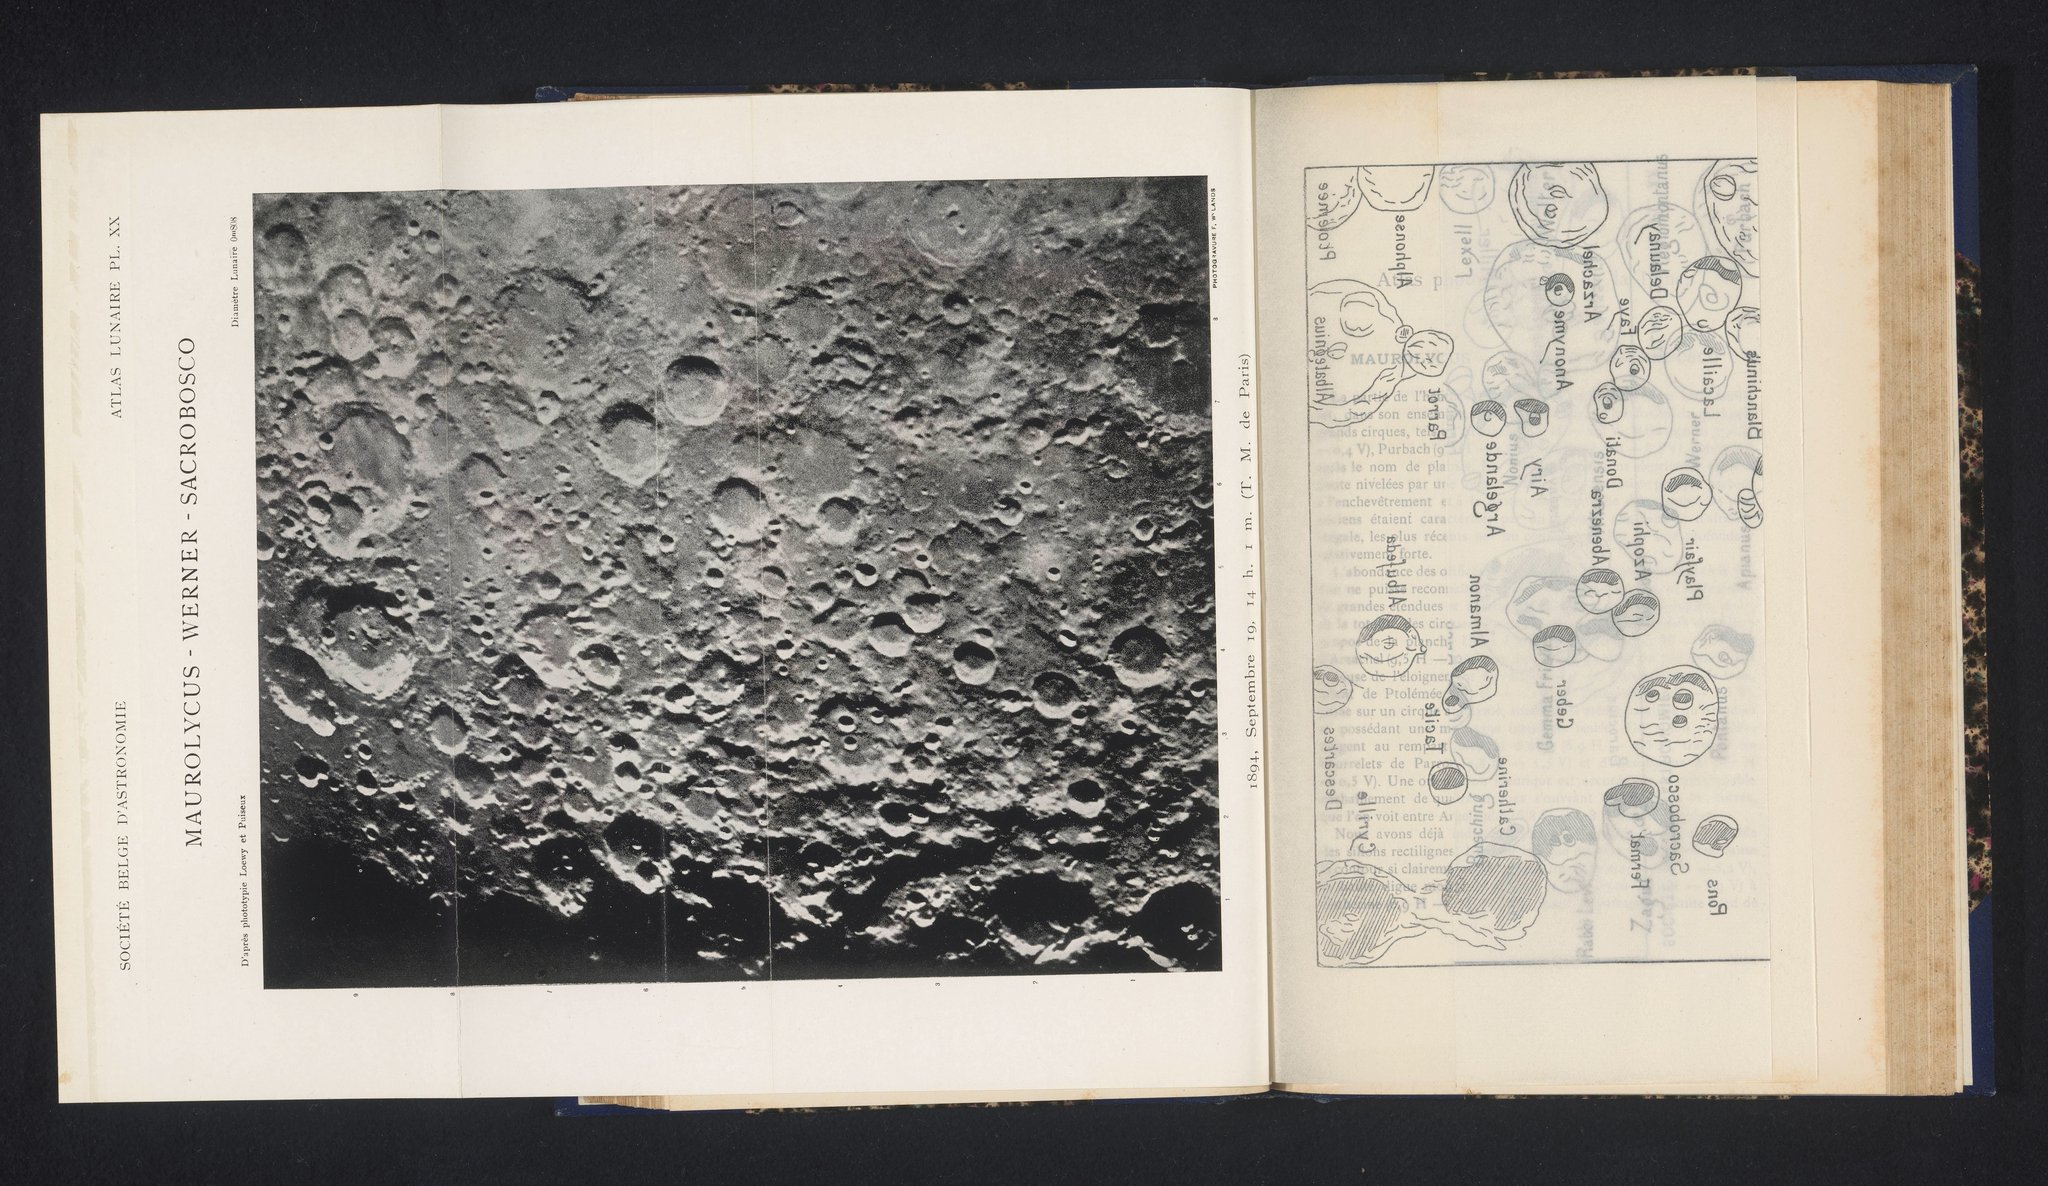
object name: page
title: Kraters op de maan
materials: paper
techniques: autotype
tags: surface of the moon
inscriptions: inscription: ‘Société Belge D'Astronomie Atlas Lunaire Pl. XX/ 1894, Septembre 19, 14 h. 1m. (T. M. de Paris)’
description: Transparante pagina voor prent als kaart met daarop de namen van de verschillende kraters.